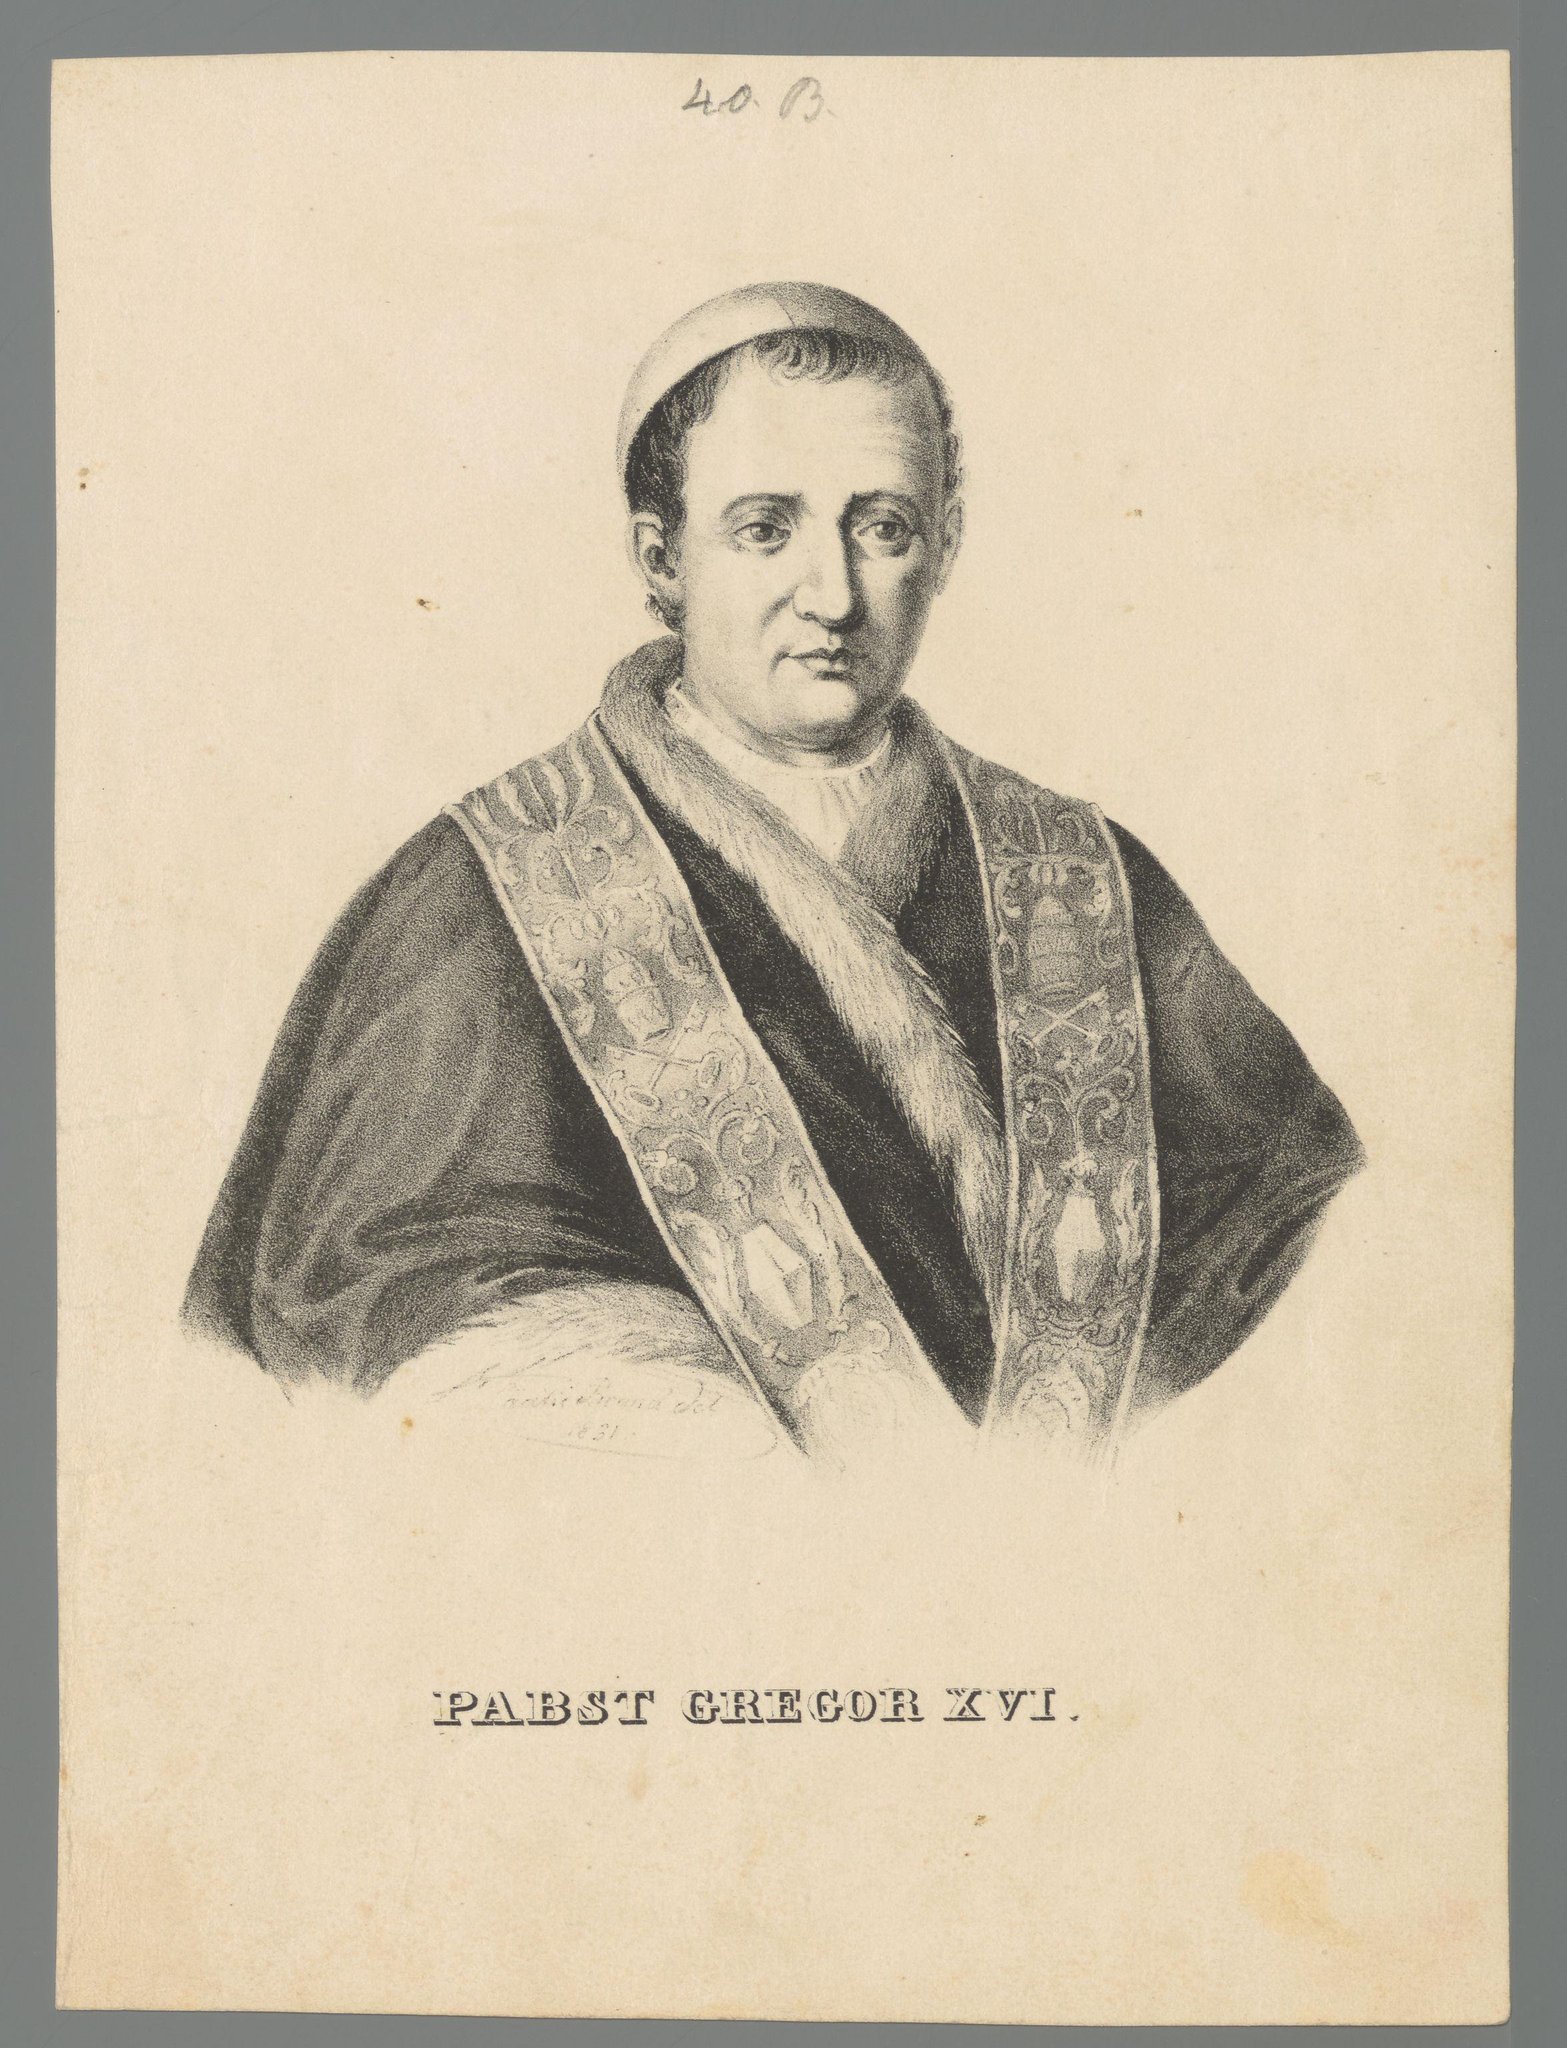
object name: print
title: Portret van Gregorius XVI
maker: cäcilie brandt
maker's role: print maker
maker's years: 1814-1852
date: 1831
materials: paper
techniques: lithograph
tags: adult man, historical persons, pope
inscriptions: collector's mark: Lugt 2228